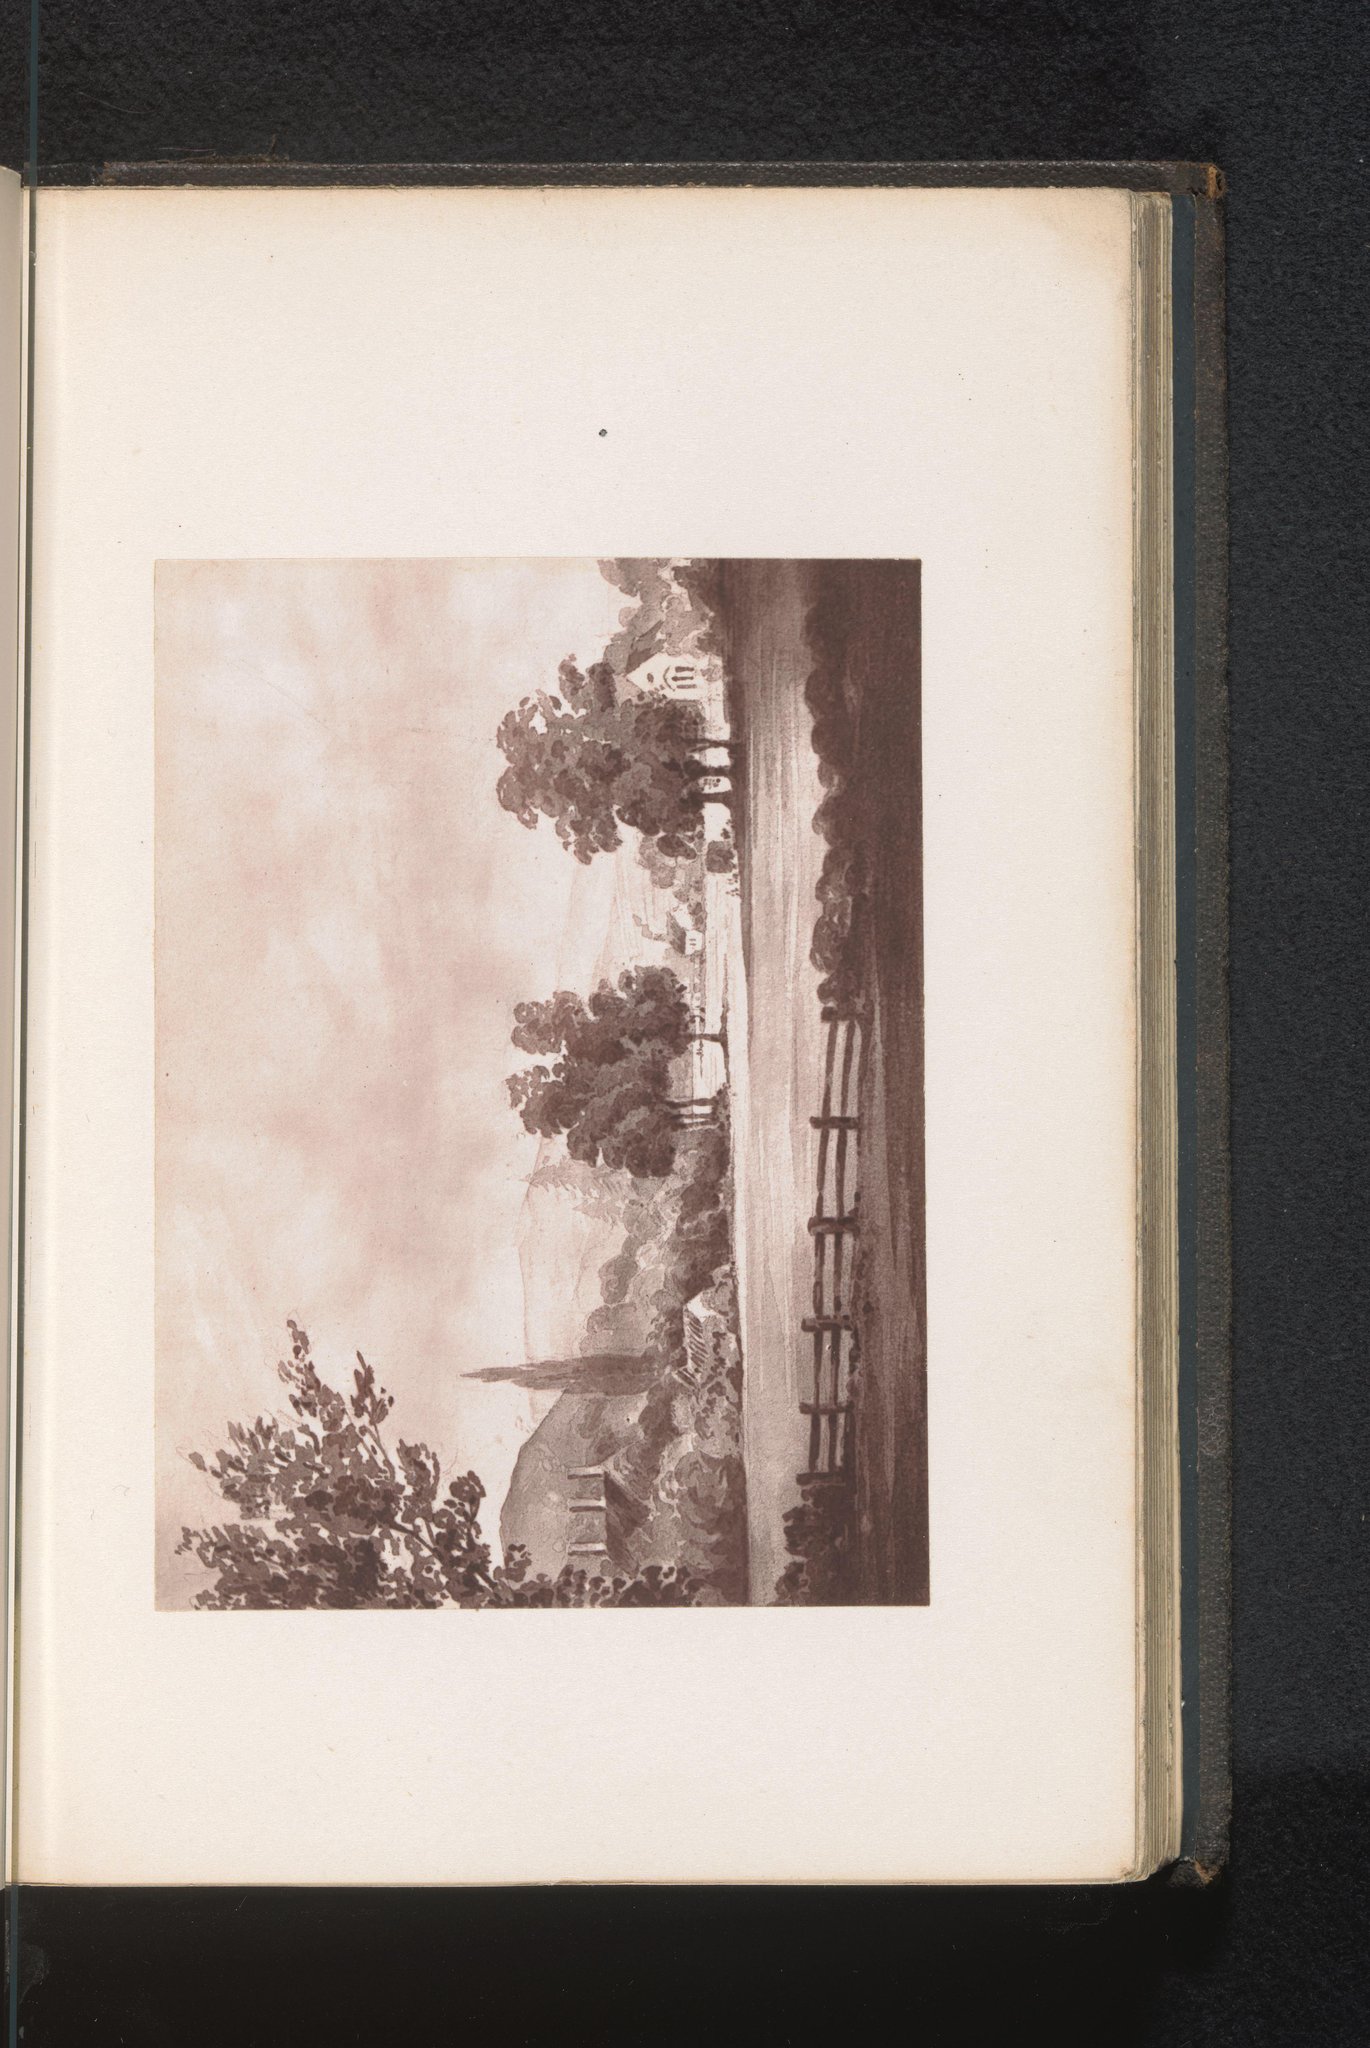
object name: page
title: Fotoreproductie van een schildering, voorstellende een gezicht op Alton Barnes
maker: Anonymous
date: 1866-1876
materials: paper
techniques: woodburytype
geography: alton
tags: city-view in general; 'veduta'